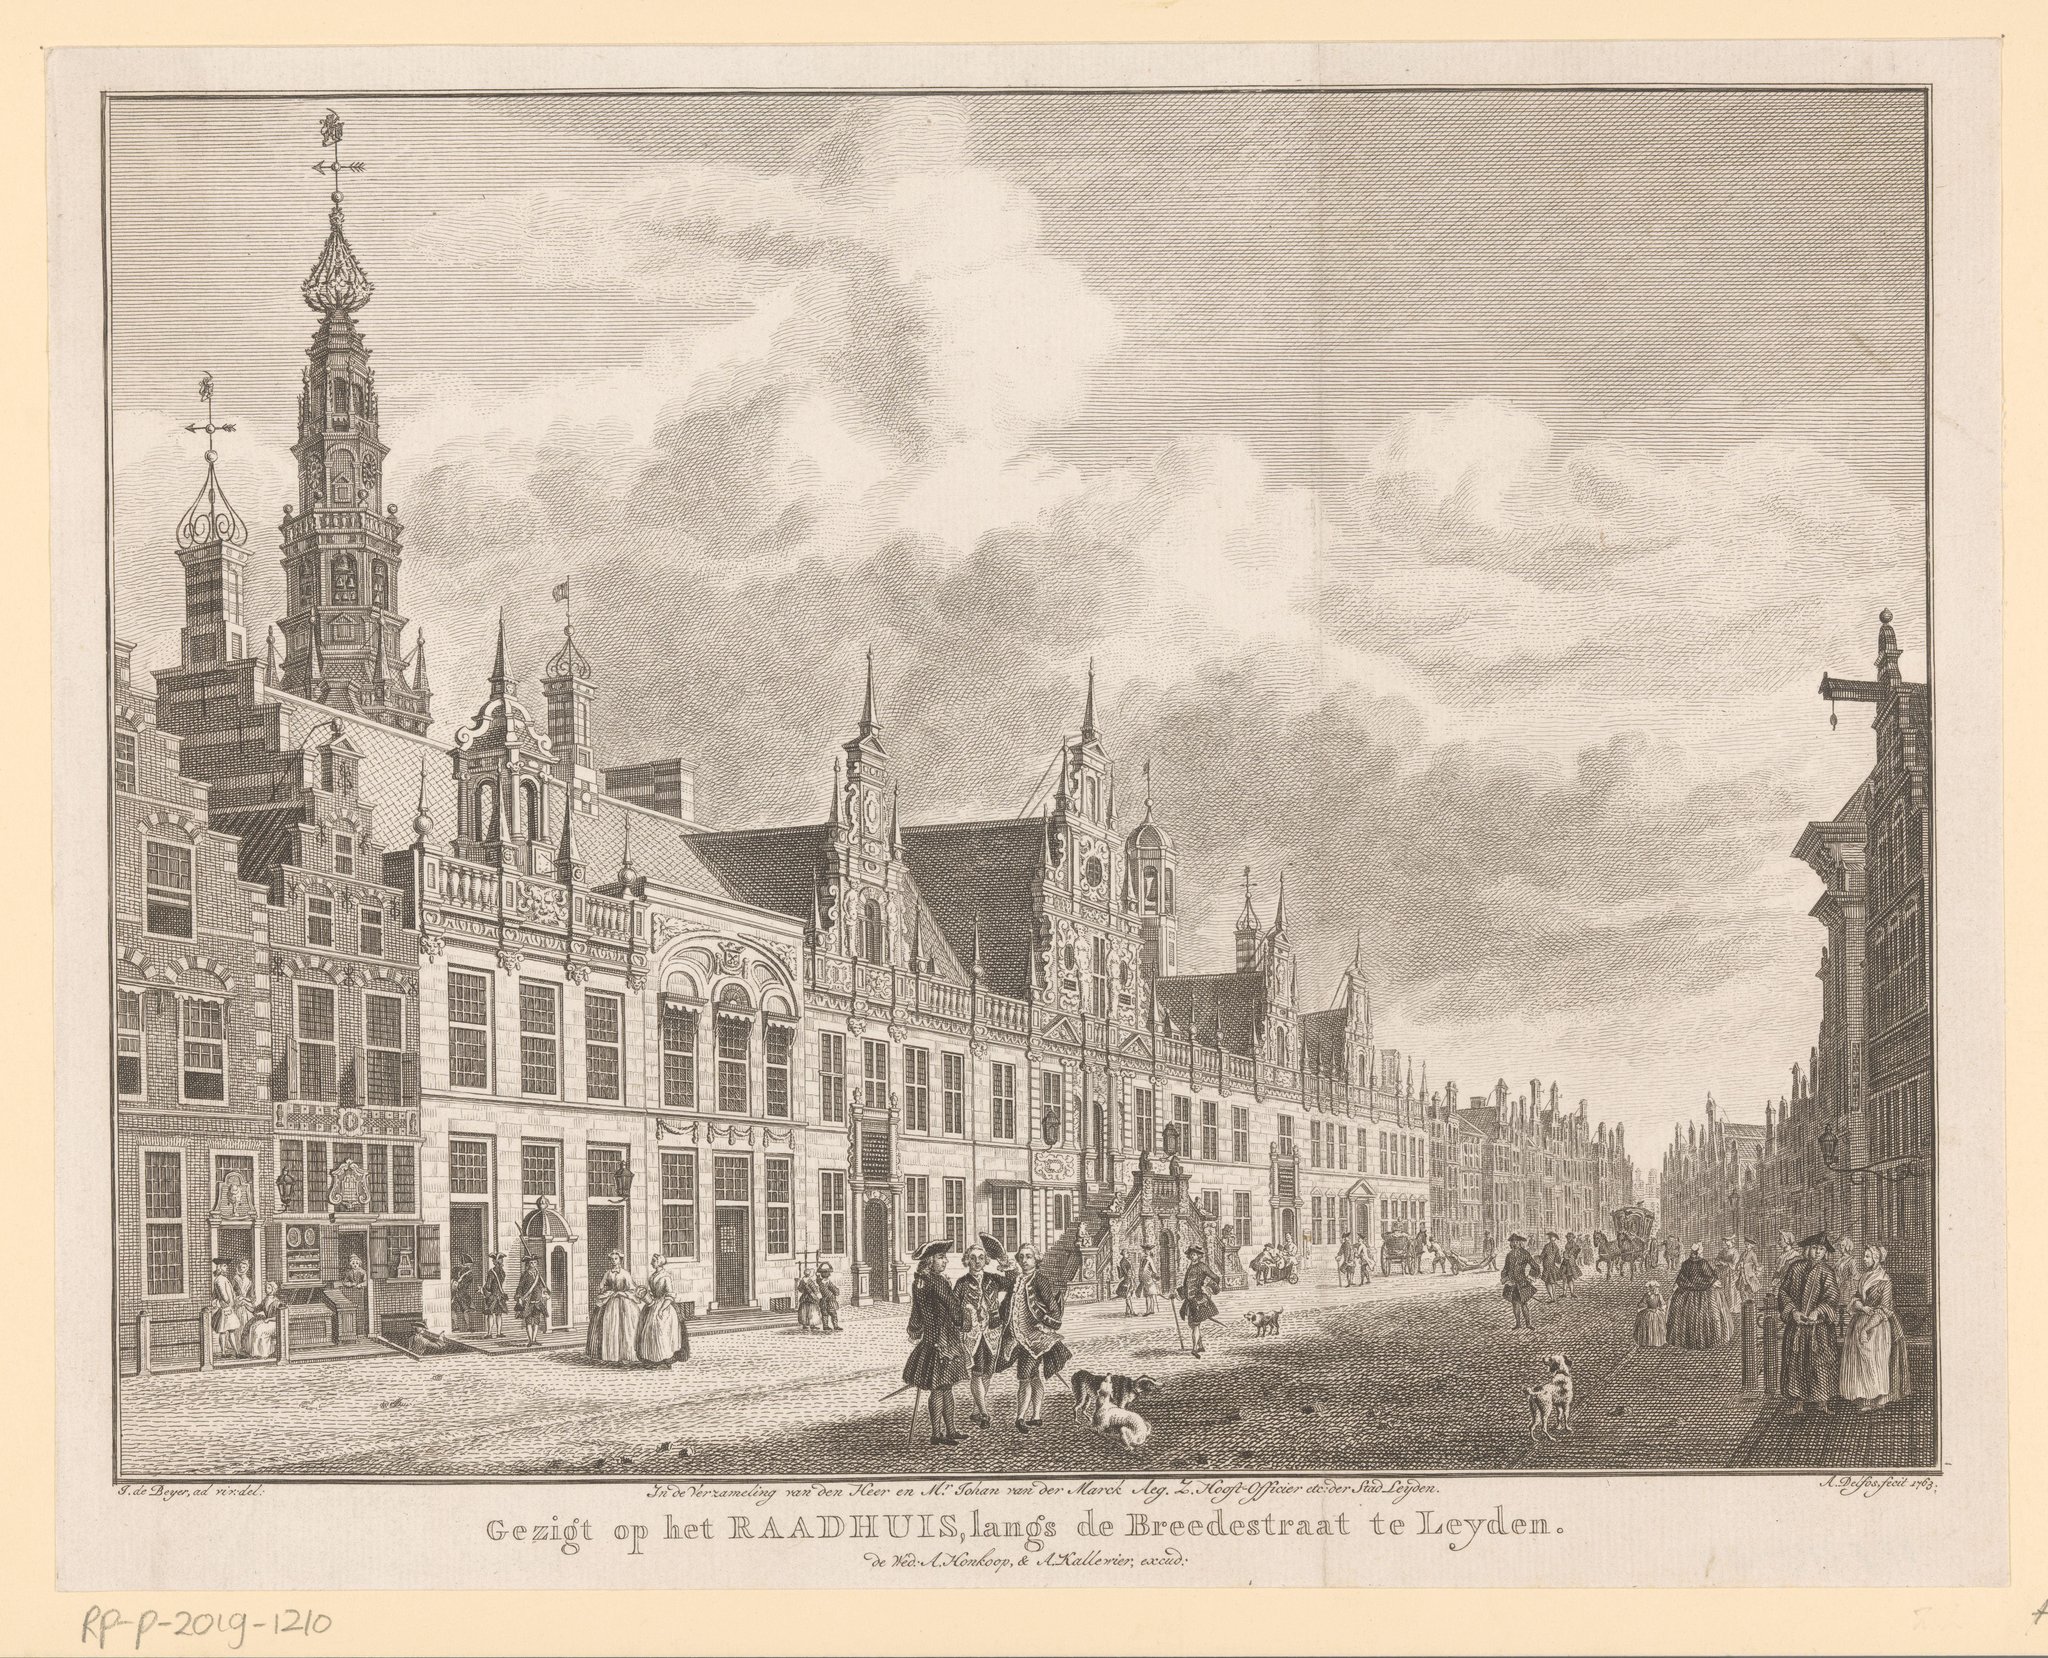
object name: print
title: Gezigt op het Raadhuis, langs de Breedestraat te Leyden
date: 1763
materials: paper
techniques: etching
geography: leiden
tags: townhall, street (+ city(-scape) with figures, staffage)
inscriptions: date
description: Prent later gebruikt in: Beschrijving der stad Leyden, haar gelegenheid, oorsprong (...). Leiden: Weduwe Abraham Honkoop en Cornelis van Hoogeveen junior, 1770, dl. 2, tussen p. 24 en 25.